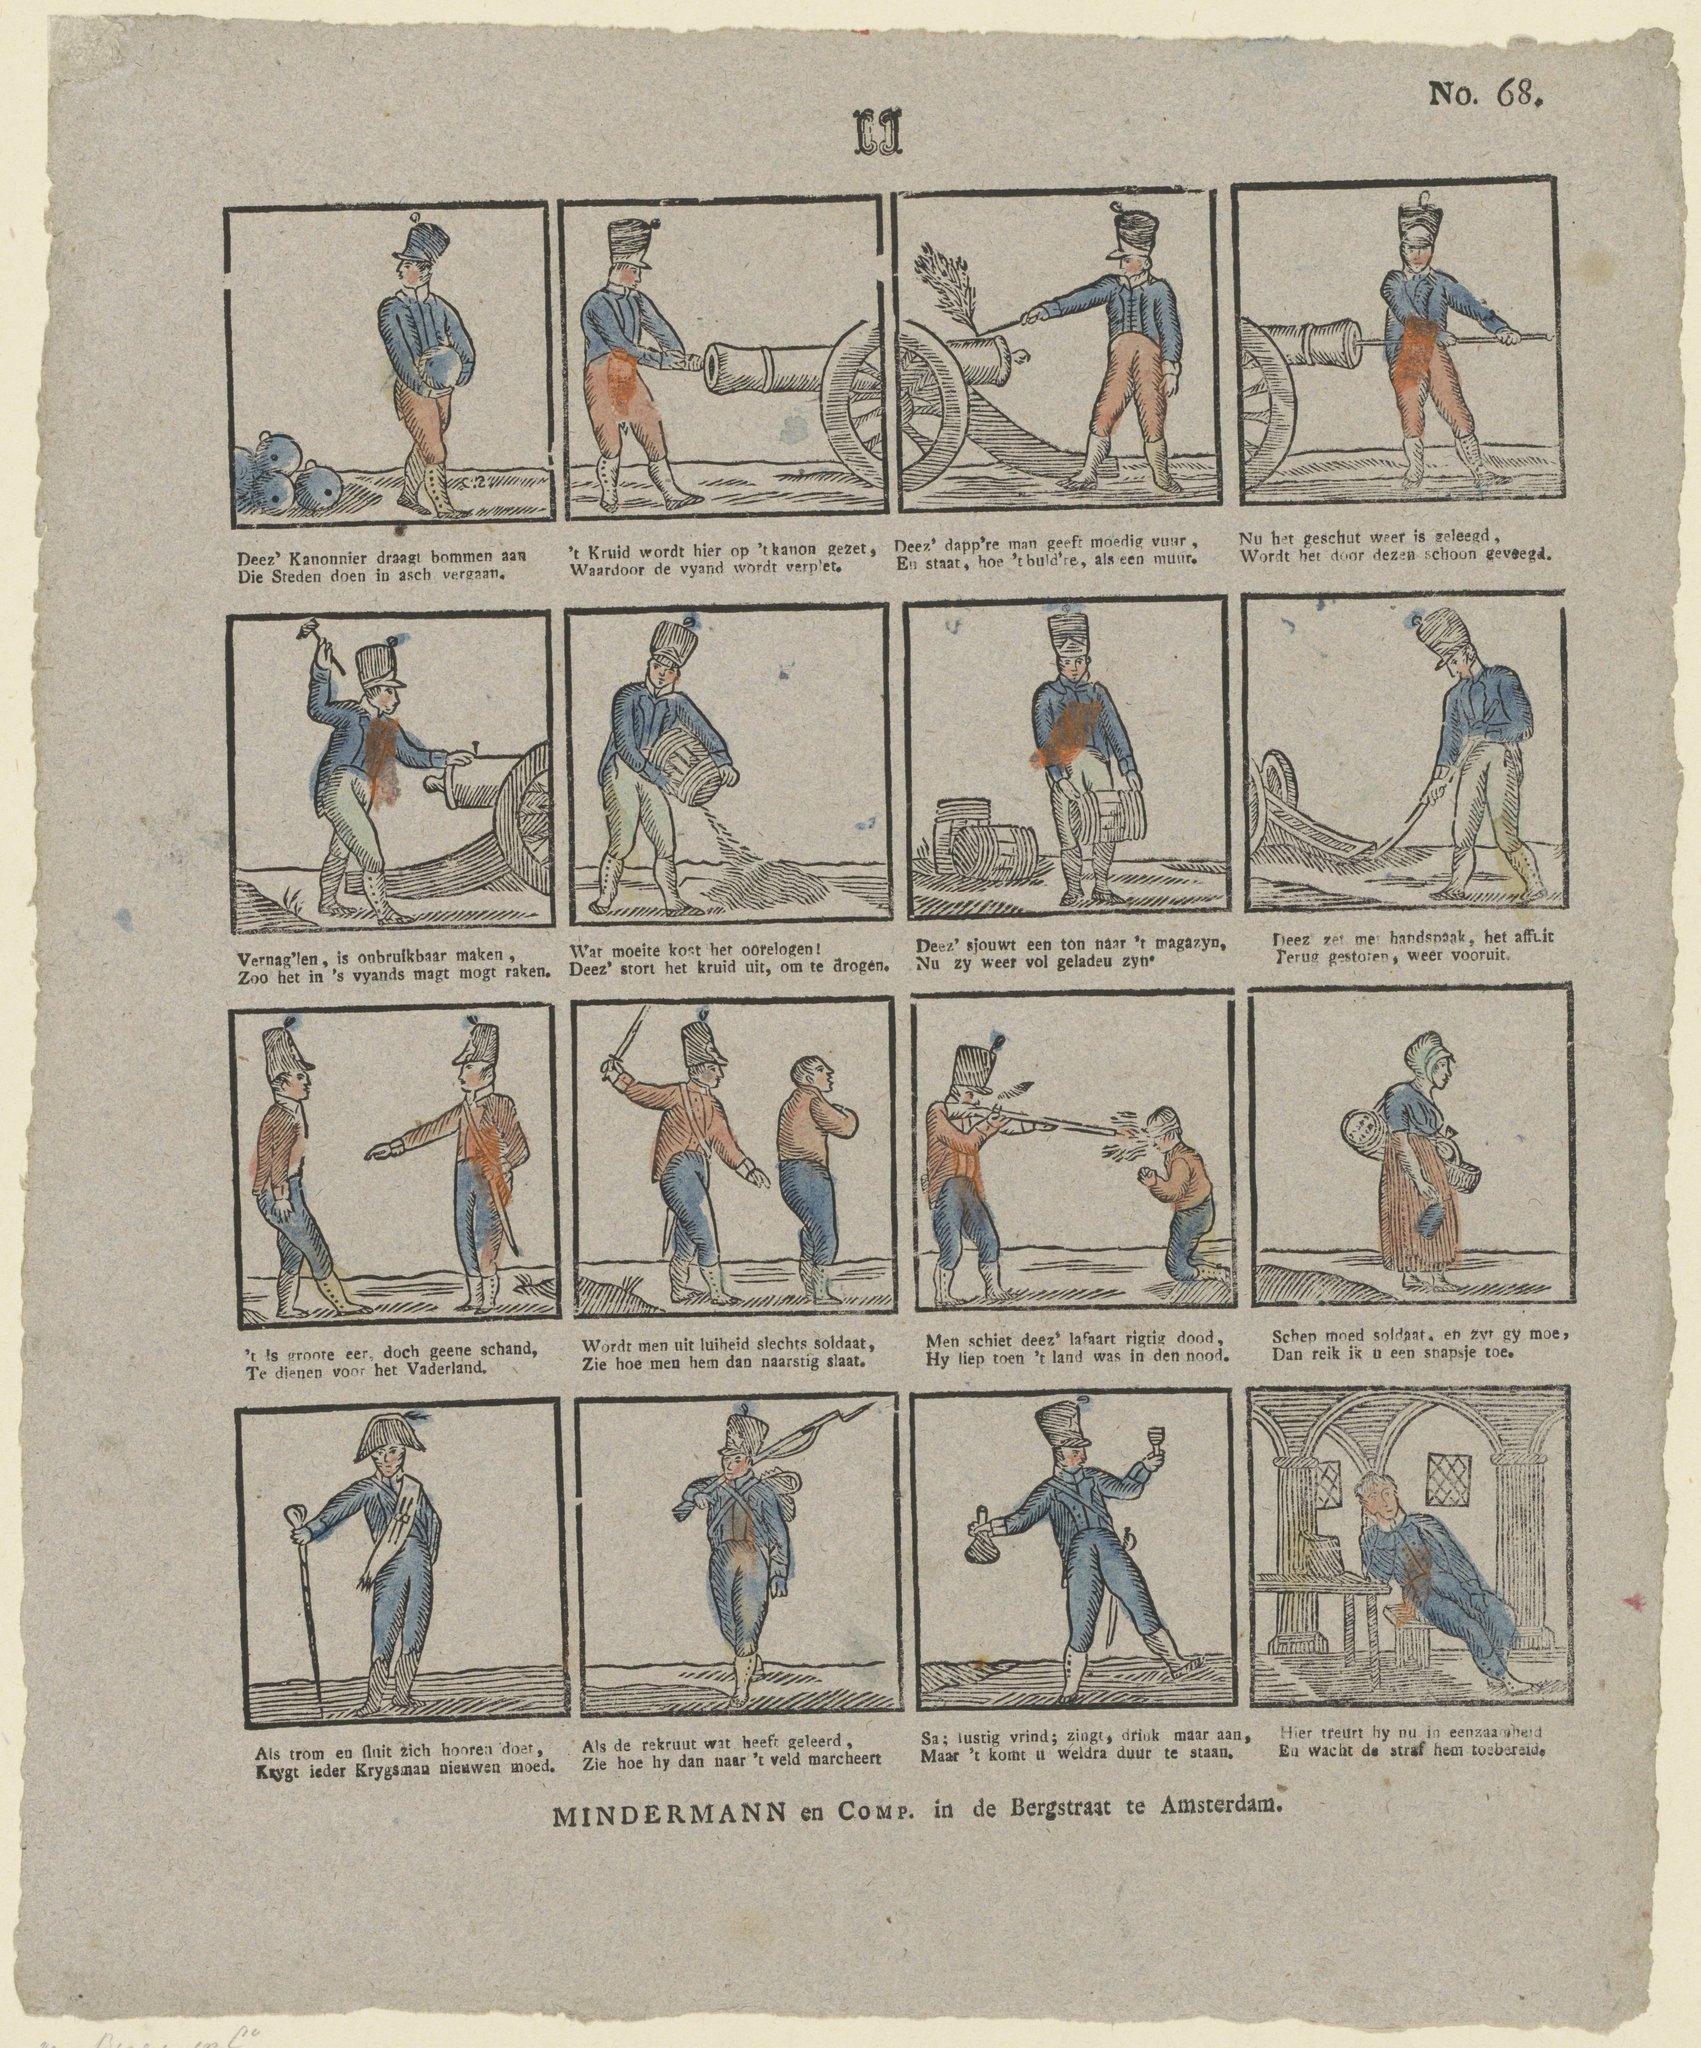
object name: print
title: Militairen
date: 1818-1848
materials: paper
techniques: colour, letterpress printing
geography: amsterdam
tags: weapons, the soldier; the soldier's life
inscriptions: collector's mark: Lugt 2760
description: Blad met 16 voorstellingen van militairen met kanonnen, kruit en zwaarden. Onder elke afbeelding een tweeregelig vers. Genummerd rechtsboven: No. 68.